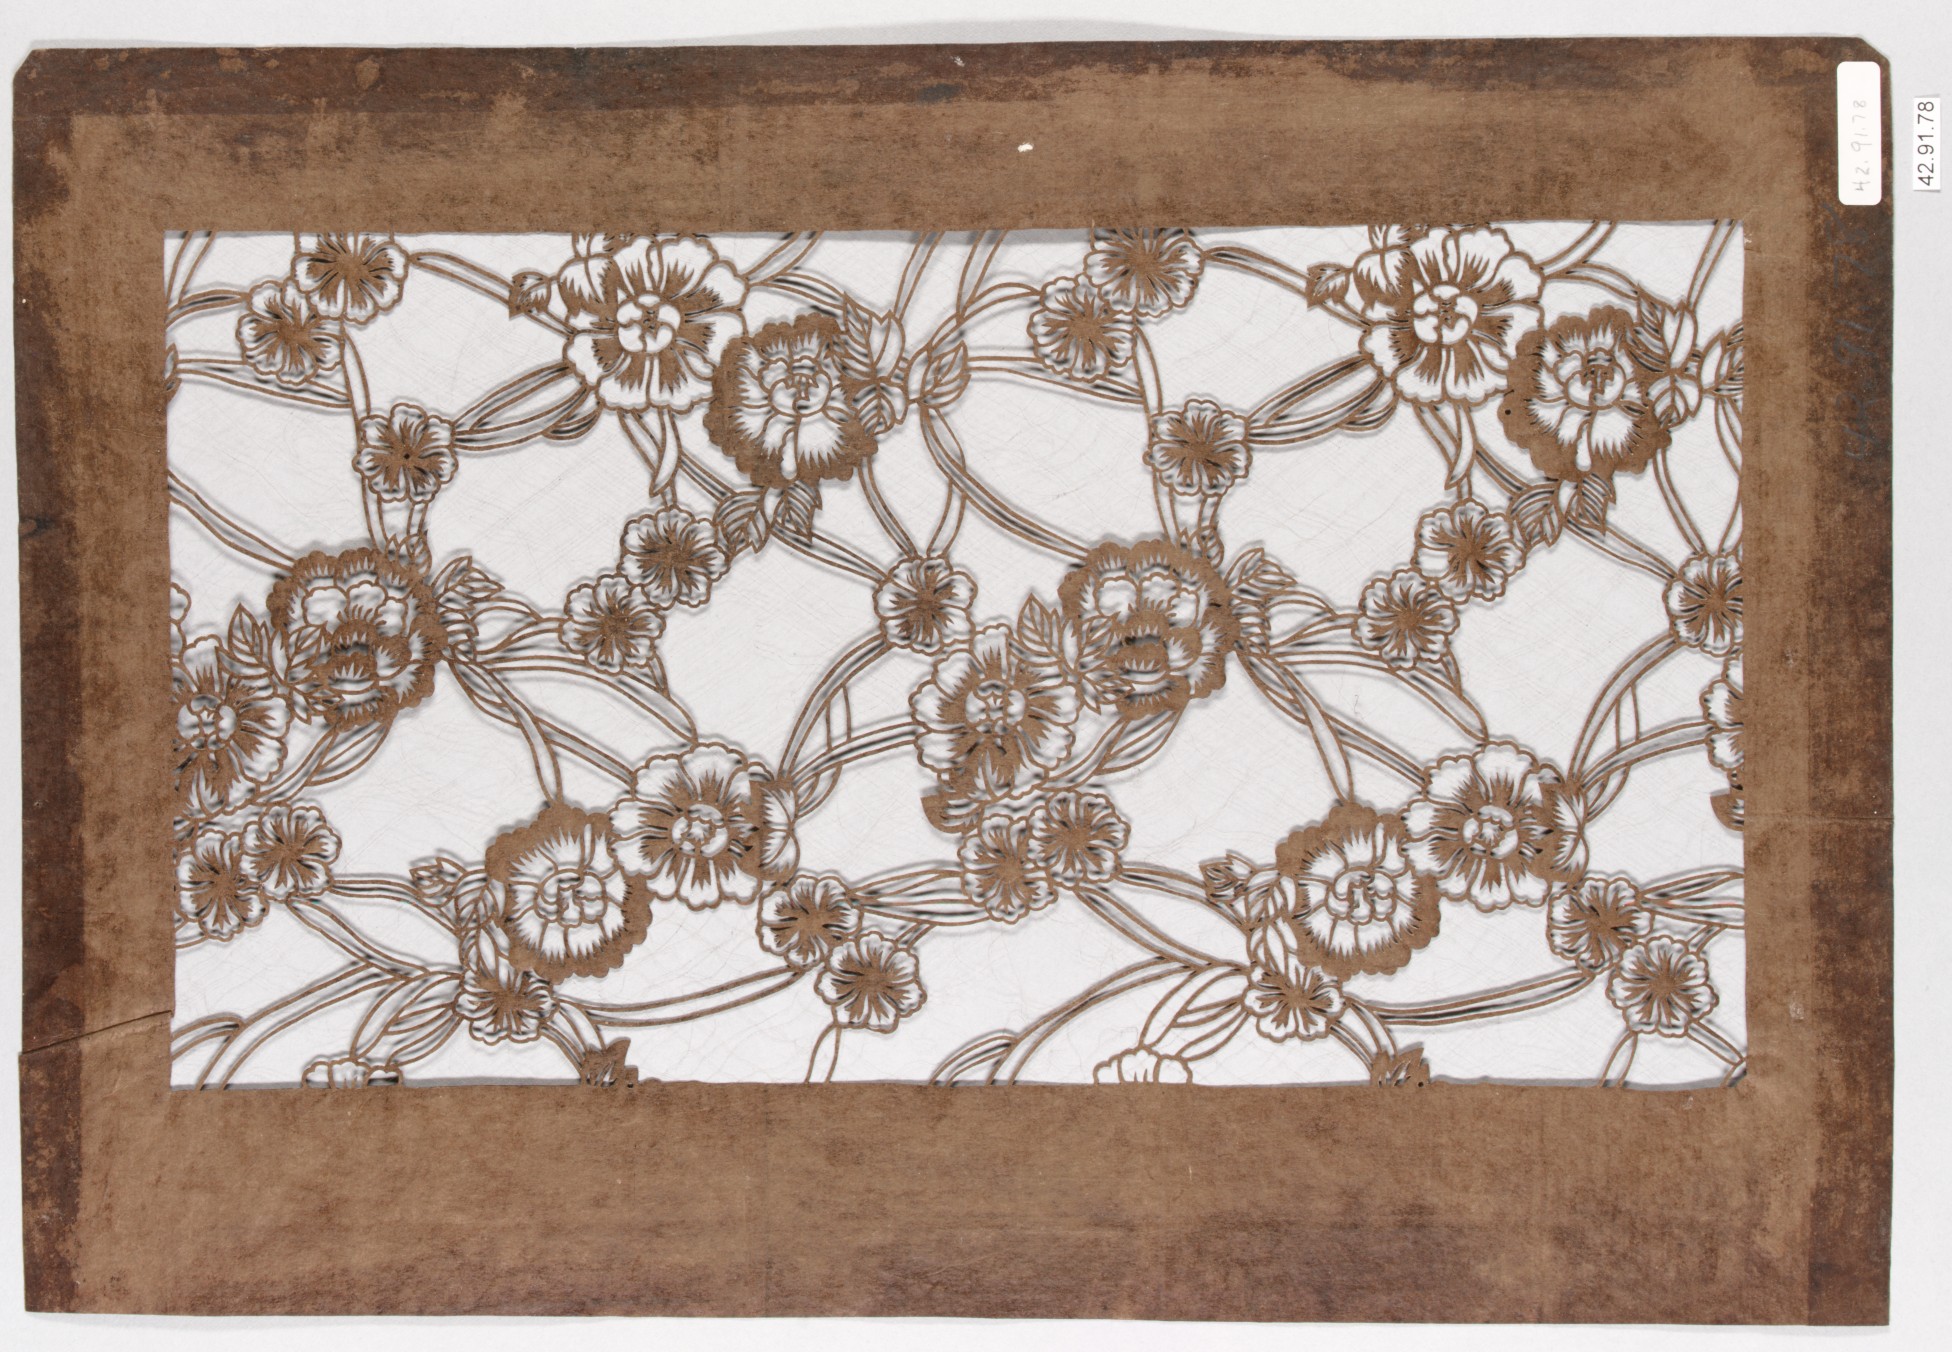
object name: stencil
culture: japanese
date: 1801-1900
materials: paper, silk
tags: flowers